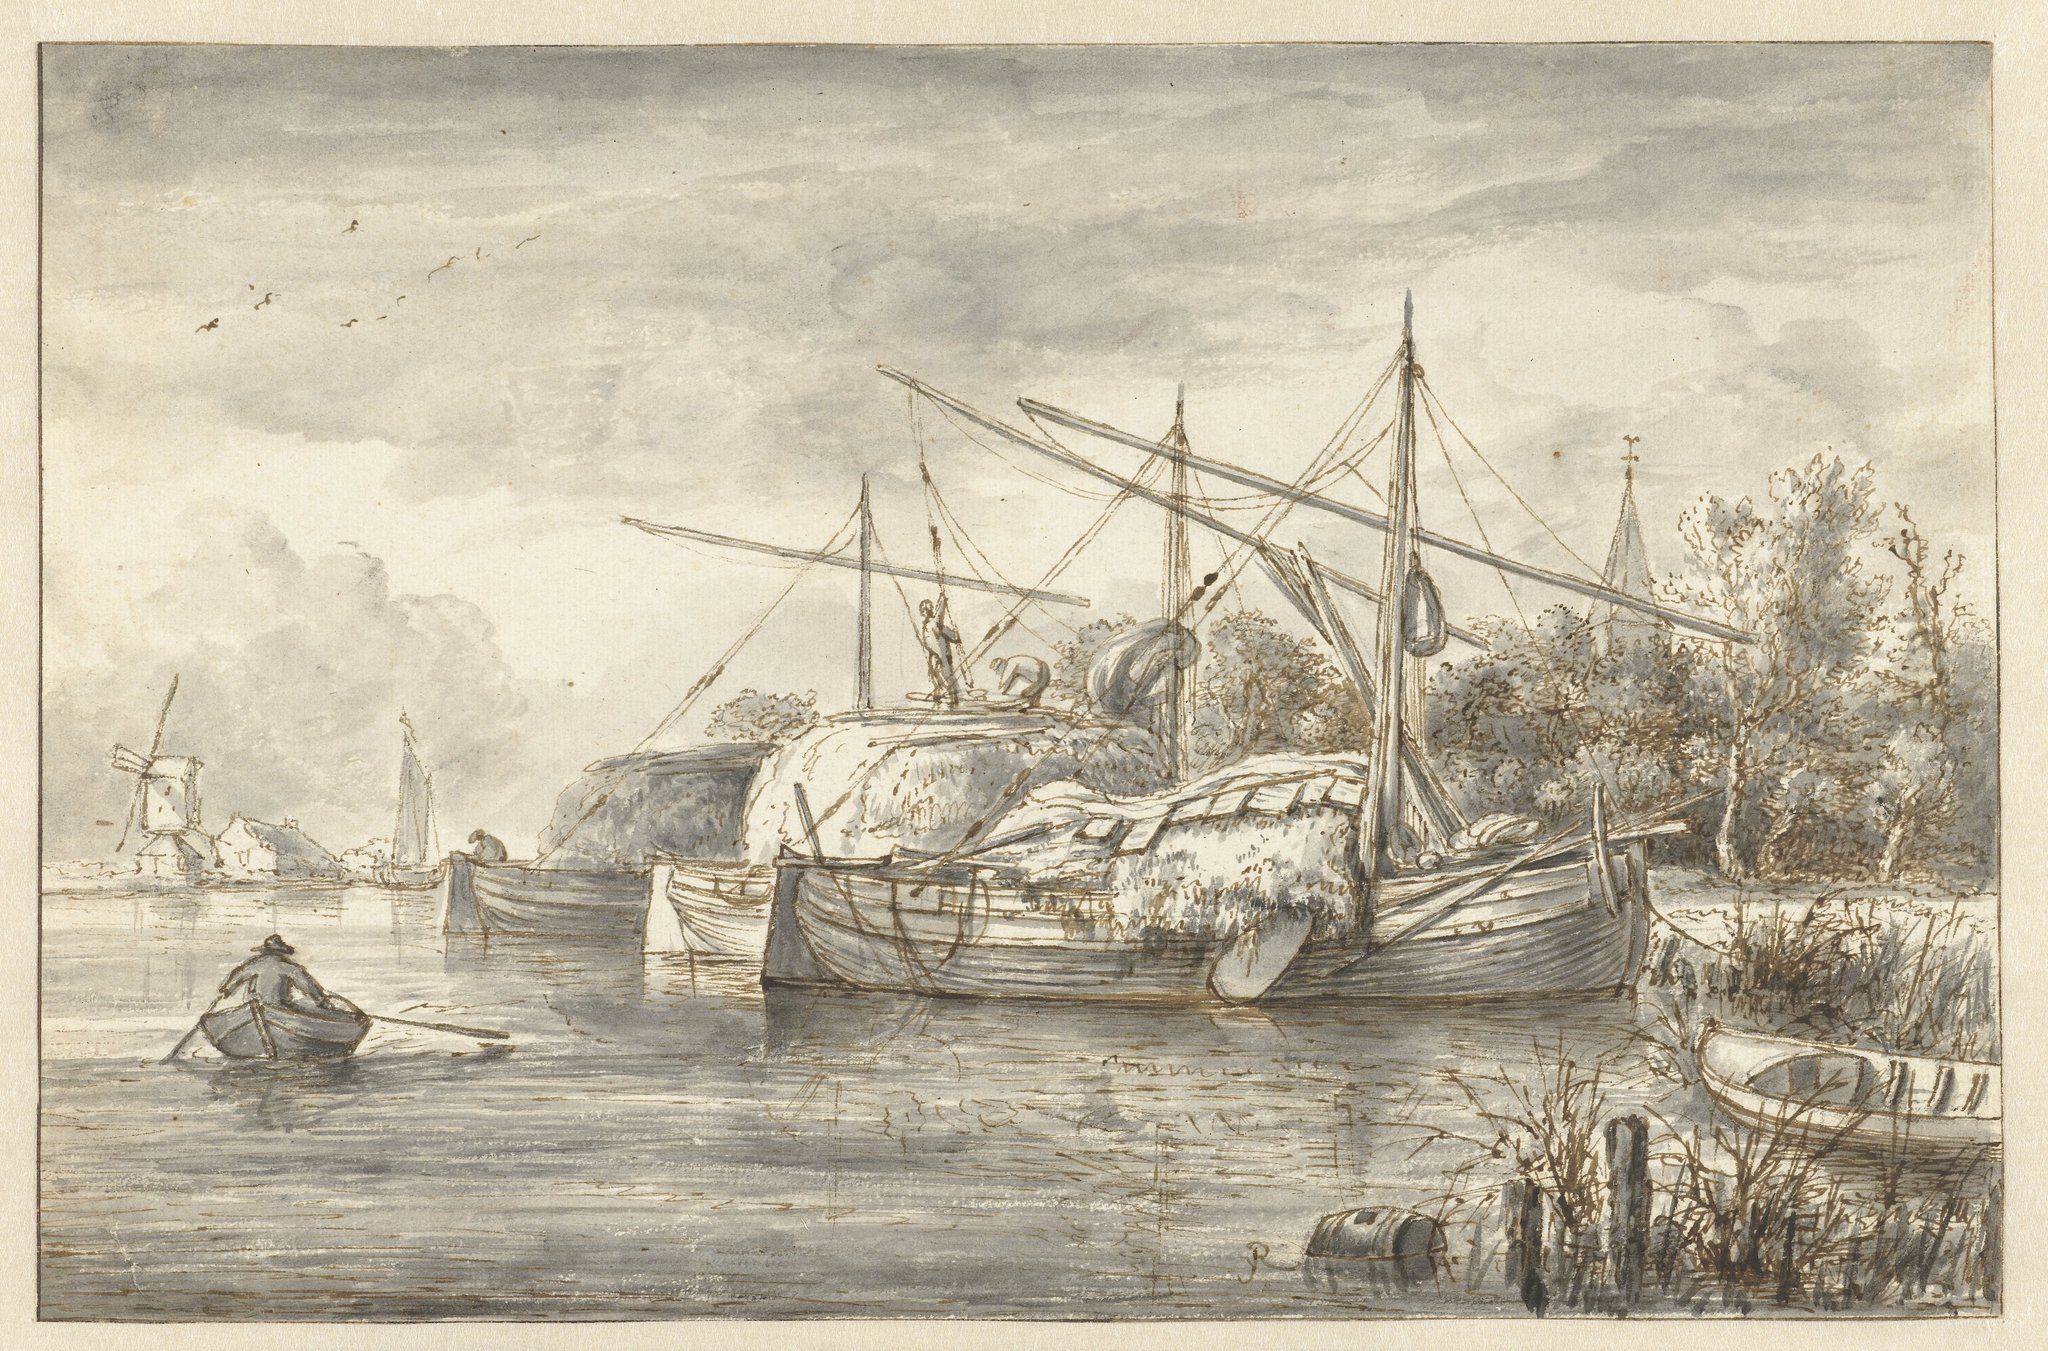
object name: drawing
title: Rivierlandschap met enkele hooischepen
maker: Anonymous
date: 1600-1699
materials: chalk, ink, paper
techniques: brush, pen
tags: agricultural products and by-products: hay, sailing-ship, sailing-boat, river